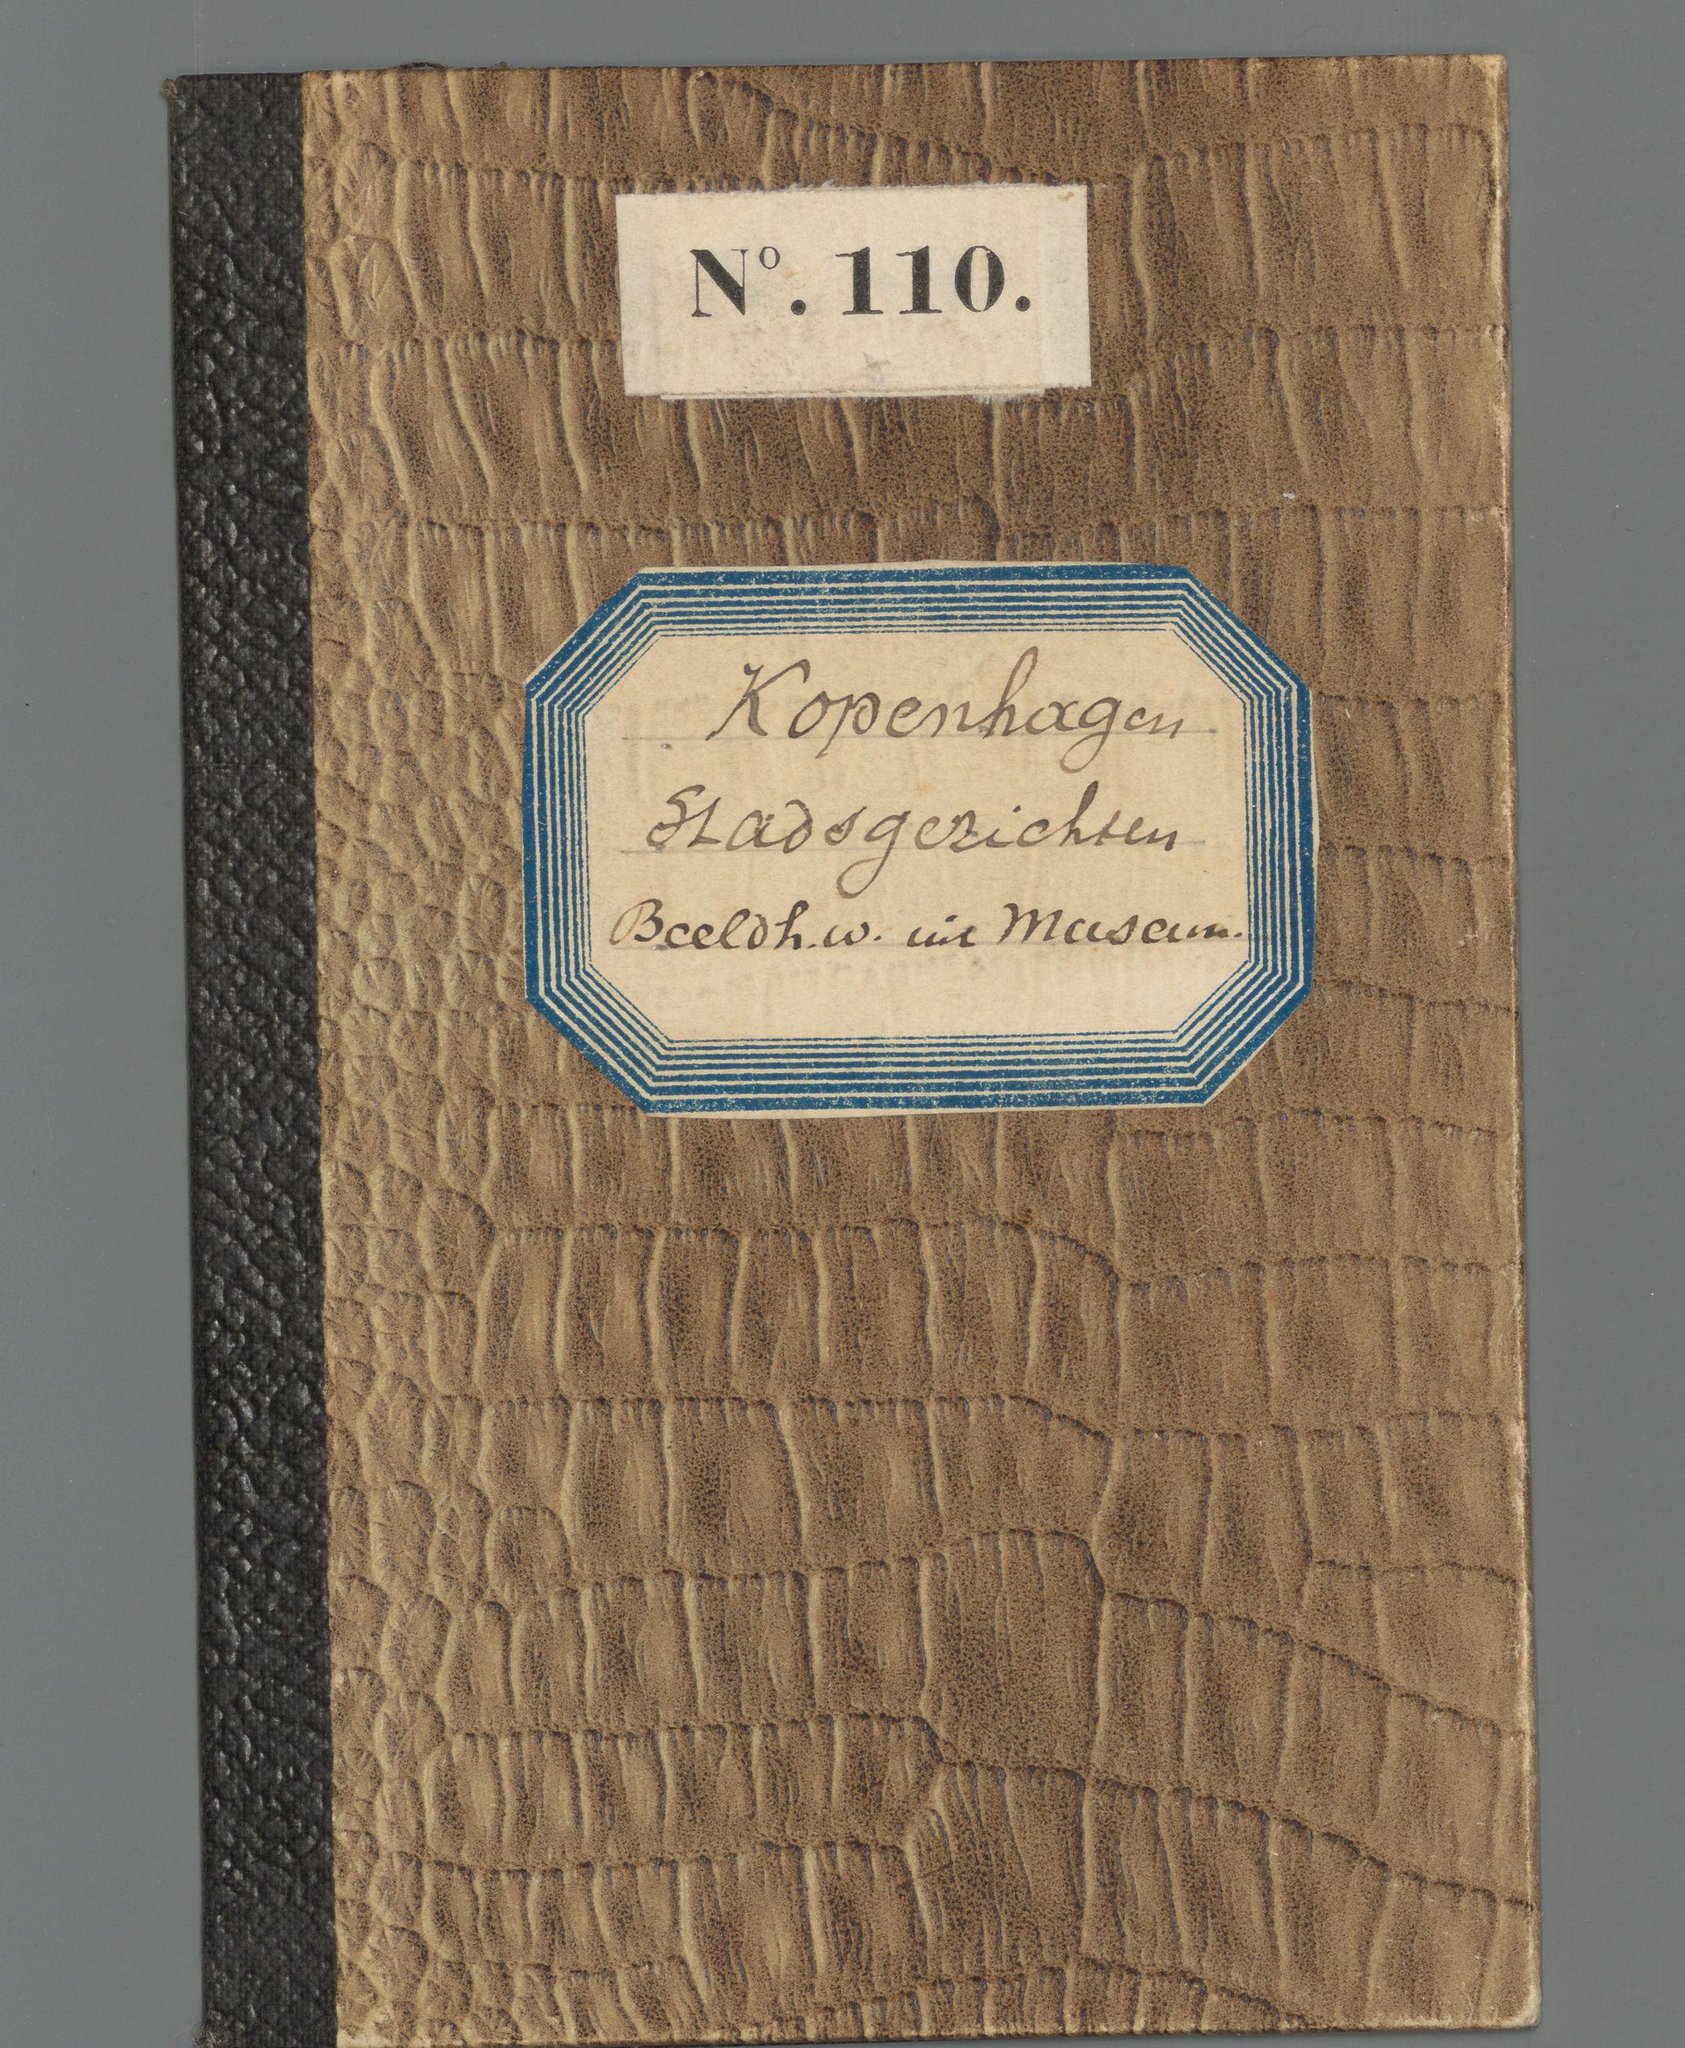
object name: wrapper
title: Kopenhagen. Stadsgezichten. Beeldh.w. uit Museum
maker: Anonymous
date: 1900-1950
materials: cardboard, ink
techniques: pen